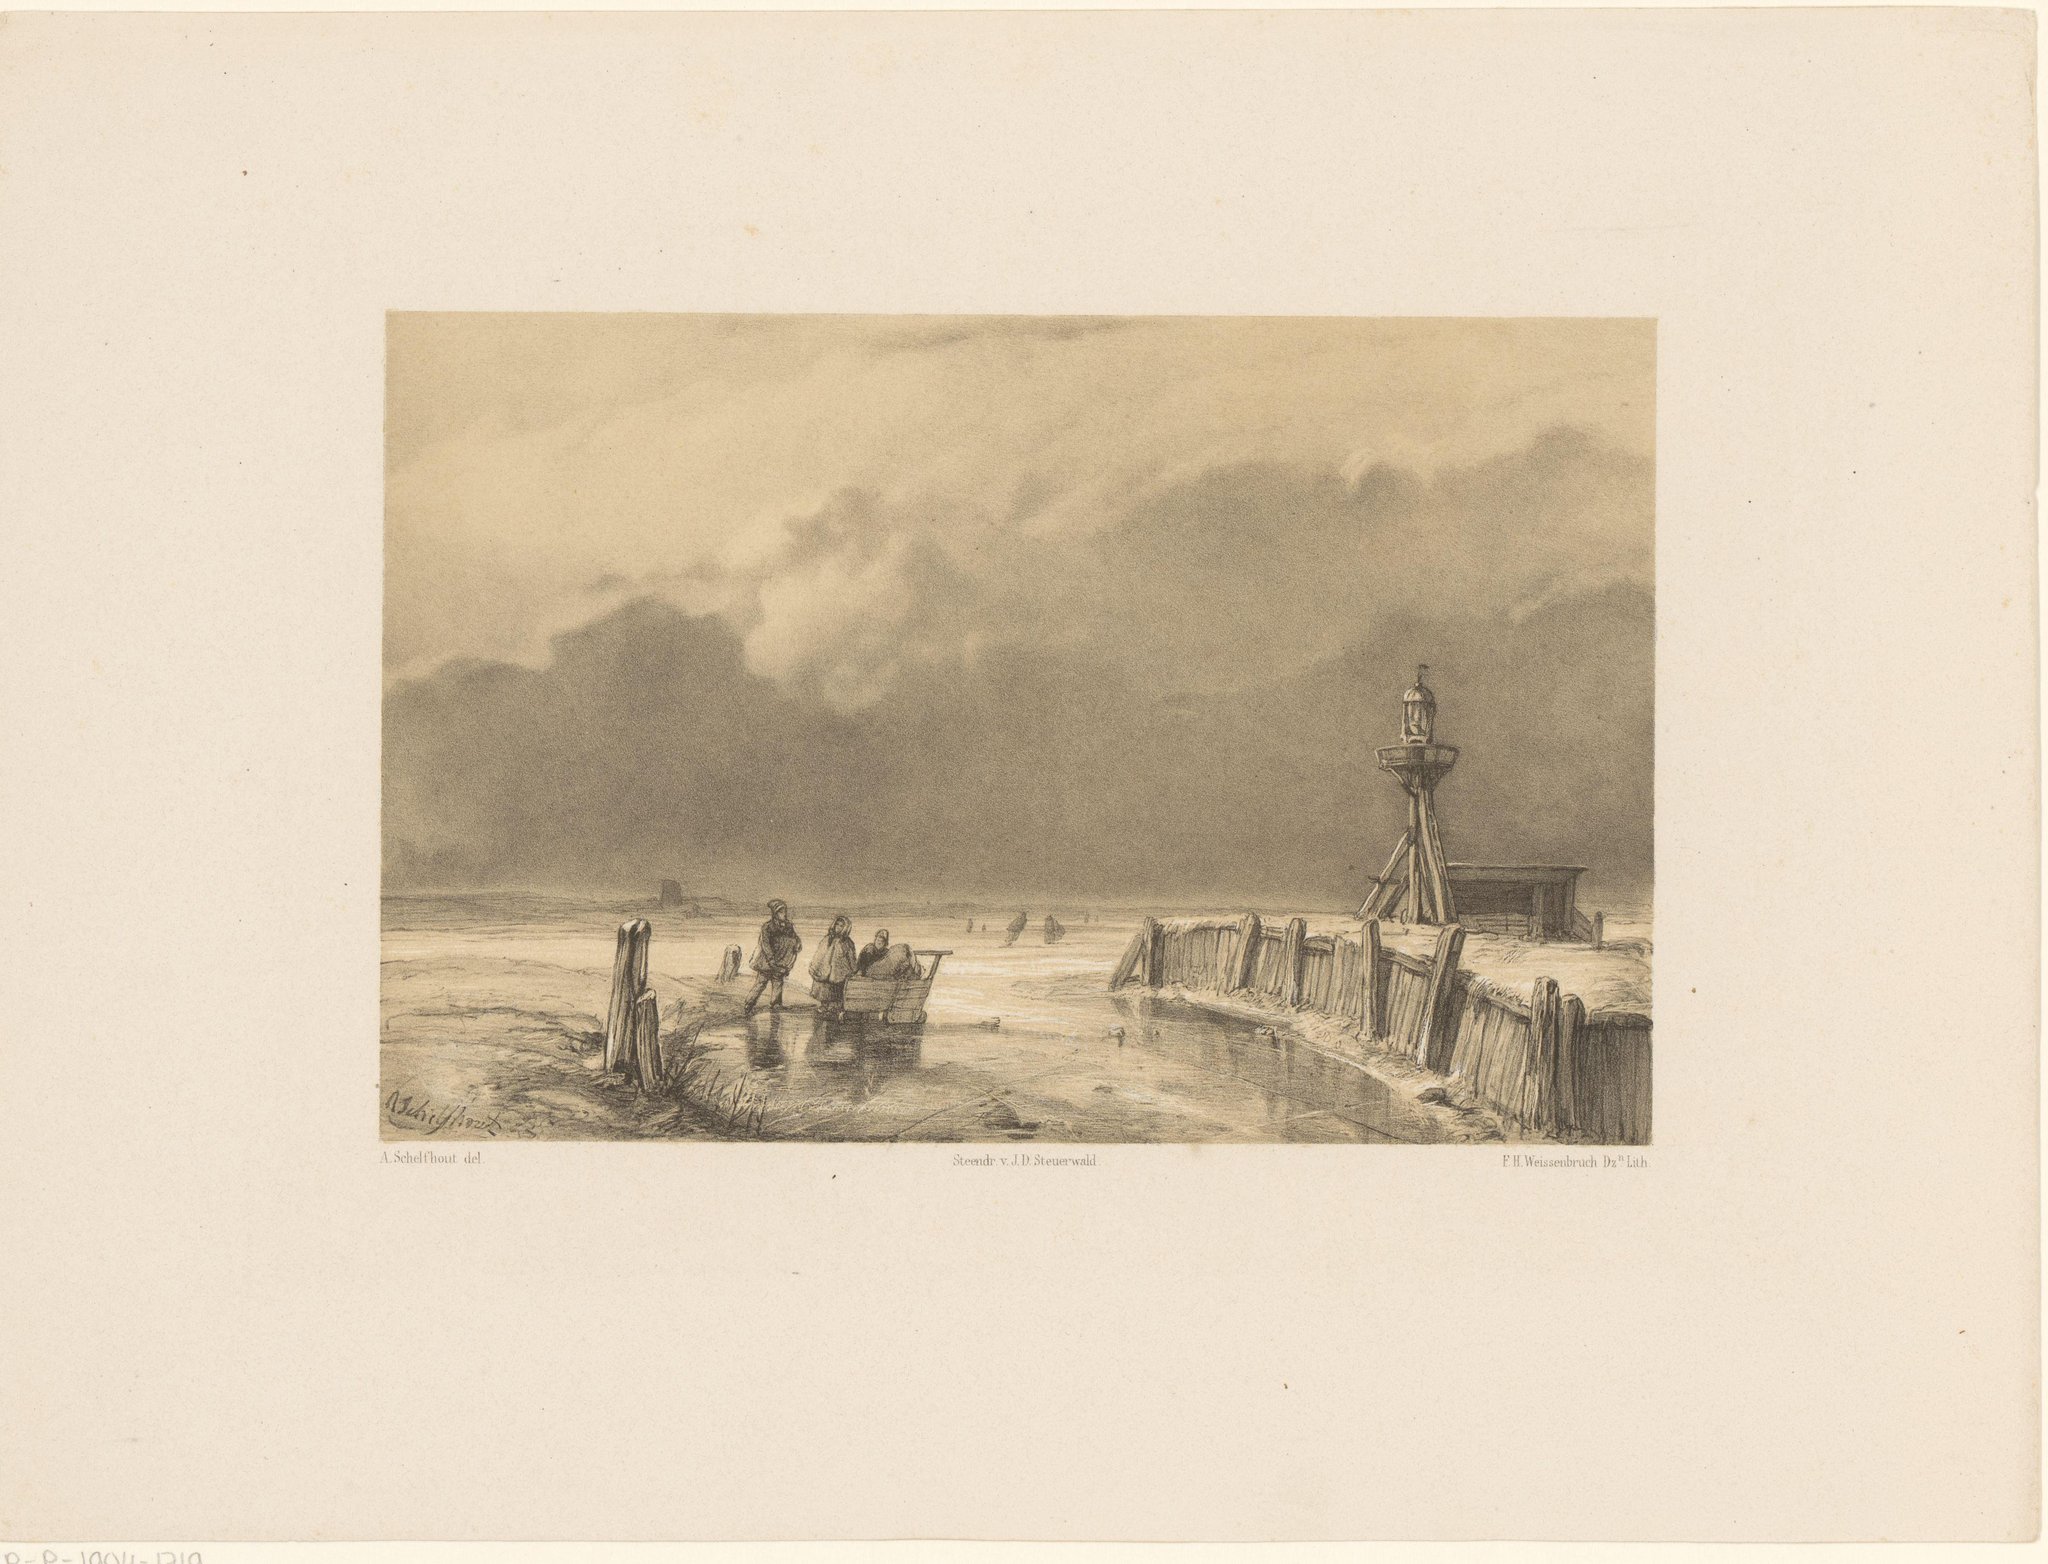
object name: print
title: IJsgezicht met vuurtoren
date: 1838-1863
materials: paper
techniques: tone lithography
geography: the hague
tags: lighthouse, lightship, sledge, sleigh (winter sports)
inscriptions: collector's mark: Lugt 2228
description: Een man, vrouw en kind staat met een slee op een bevroren vaart. Rechts een vuurtoren. In de achtergrond het bevroren meer waarop de vaart uitkomst.